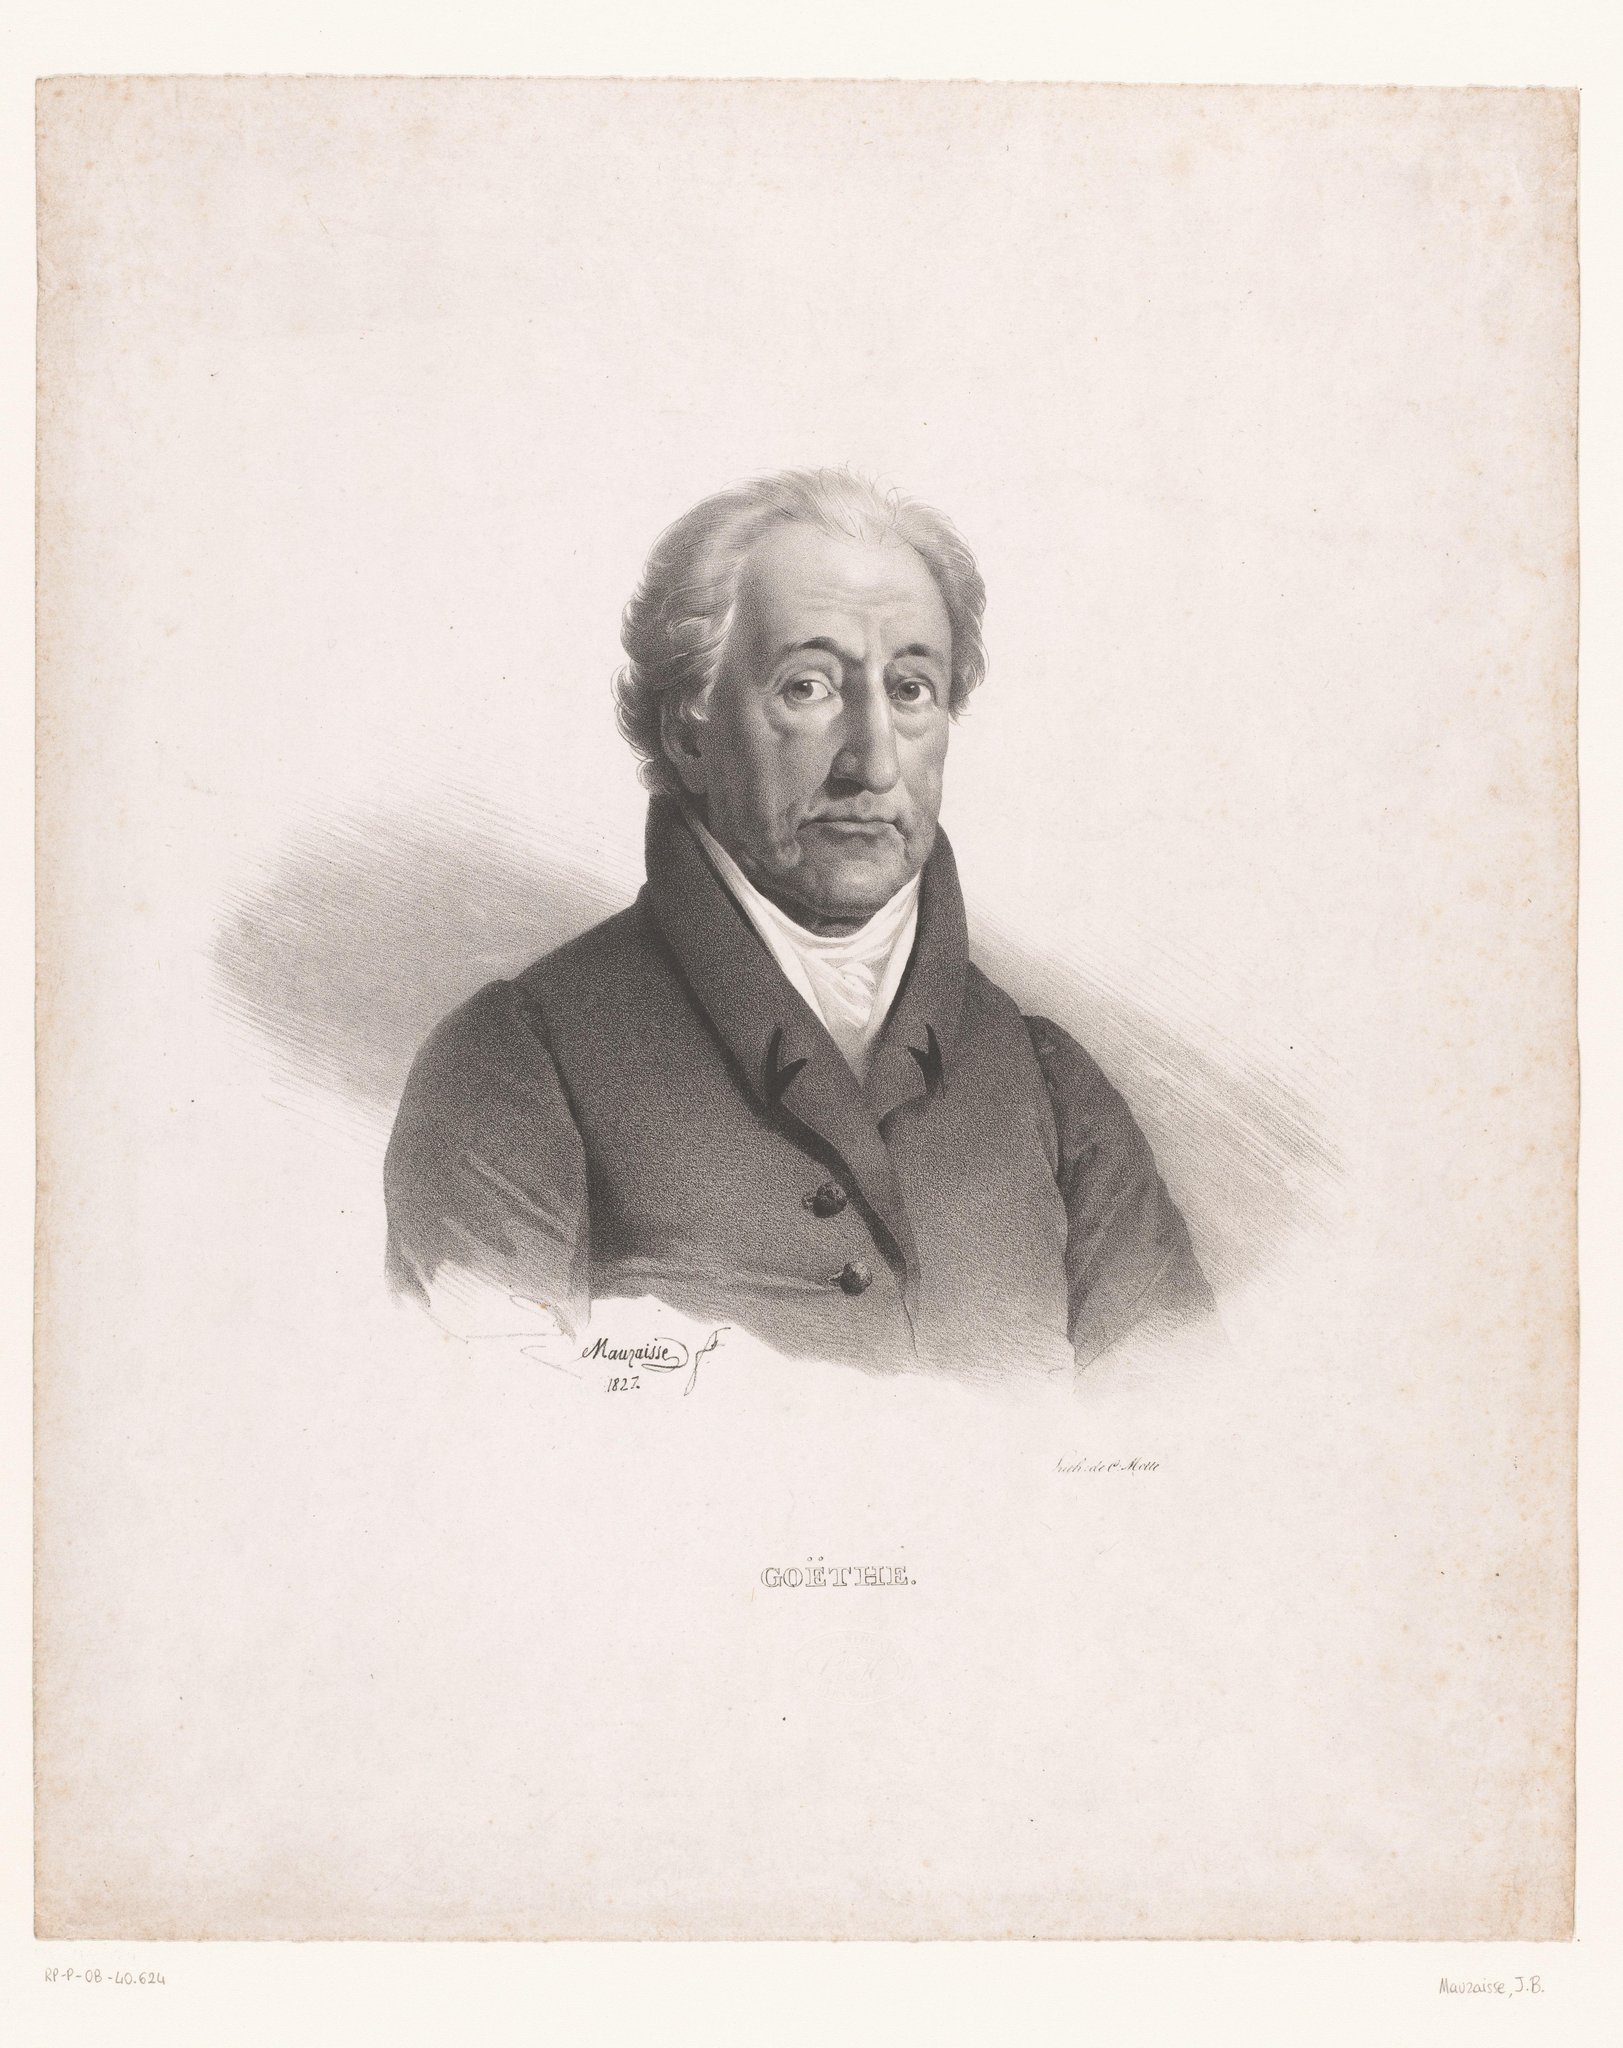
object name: print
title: Goëthe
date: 1827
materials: paper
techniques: lithograph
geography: paris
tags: draughtsman, johann wolfgang von goethe, historical persons, writer, poet, author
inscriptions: collector's mark: Lugt 2228, inscription: ‘14A 31-10-'78’, check stamp: Lugt 3996